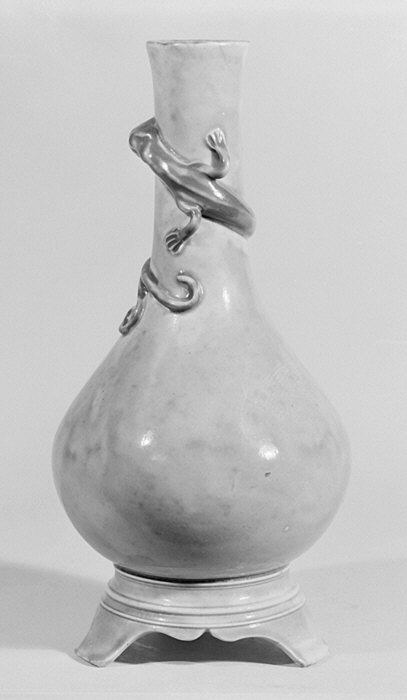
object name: bottle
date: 1750-1760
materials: stoneware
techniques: salt glaze